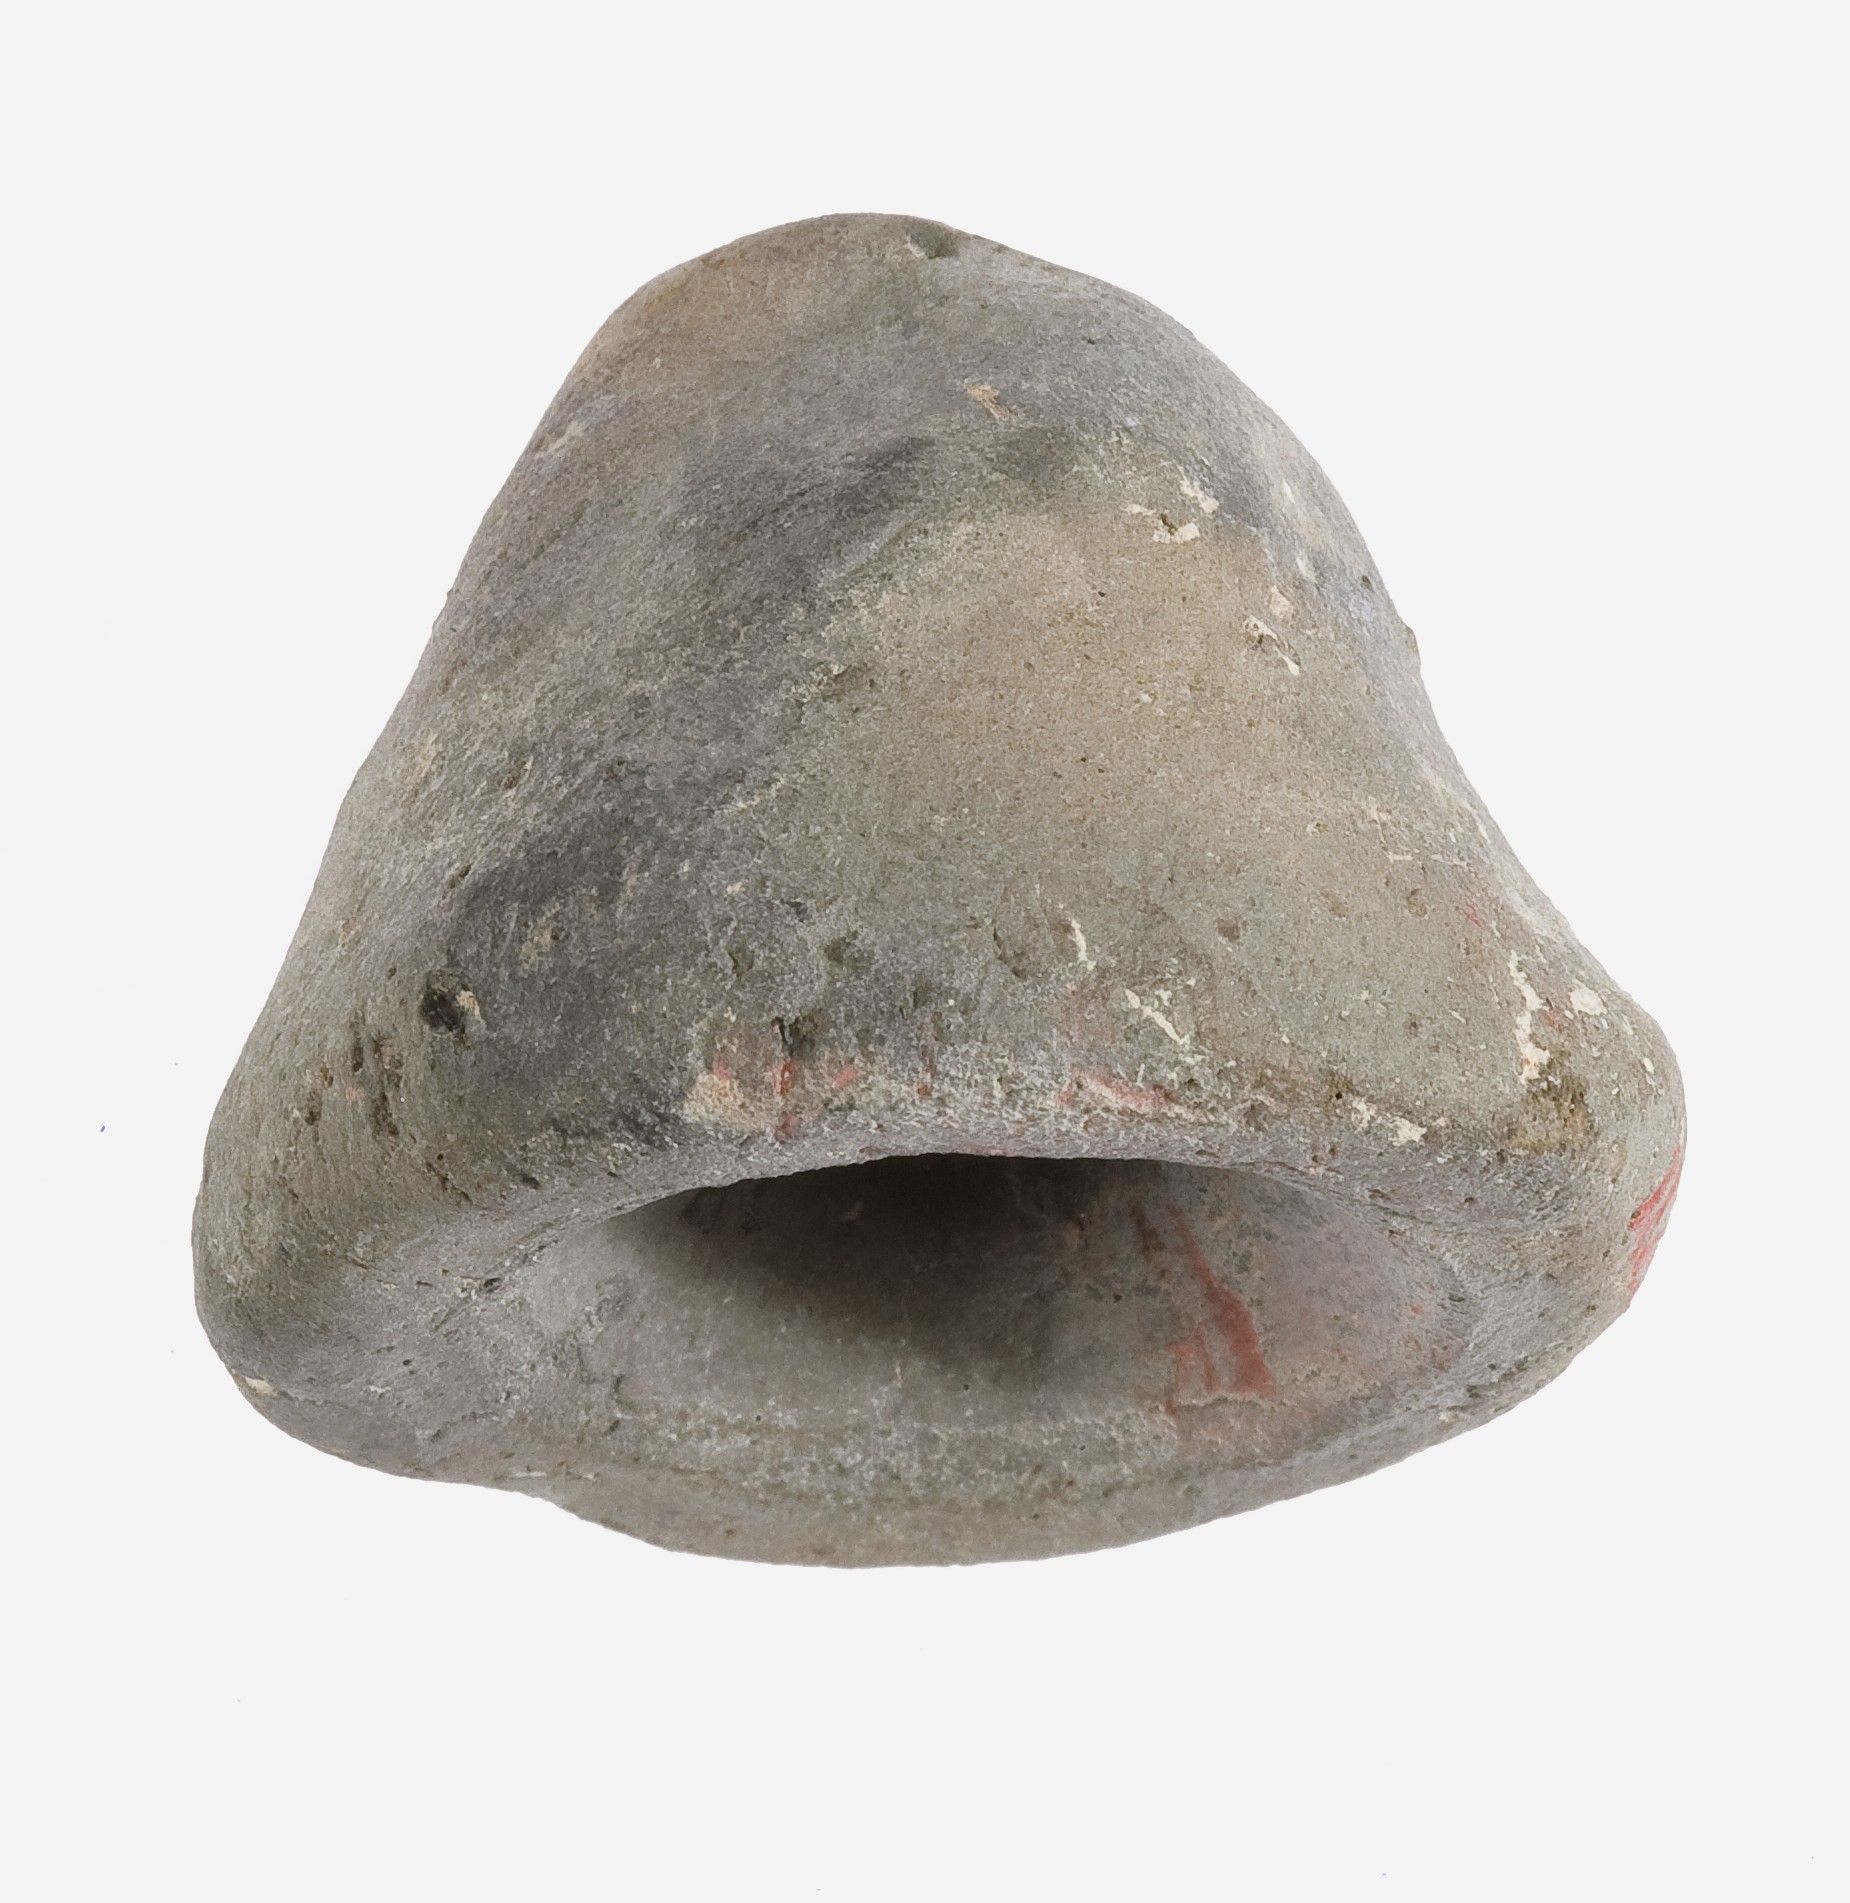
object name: mold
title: Mold for Pierced Umbel Pendant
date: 1390-1352 BCE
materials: pottery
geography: egypt